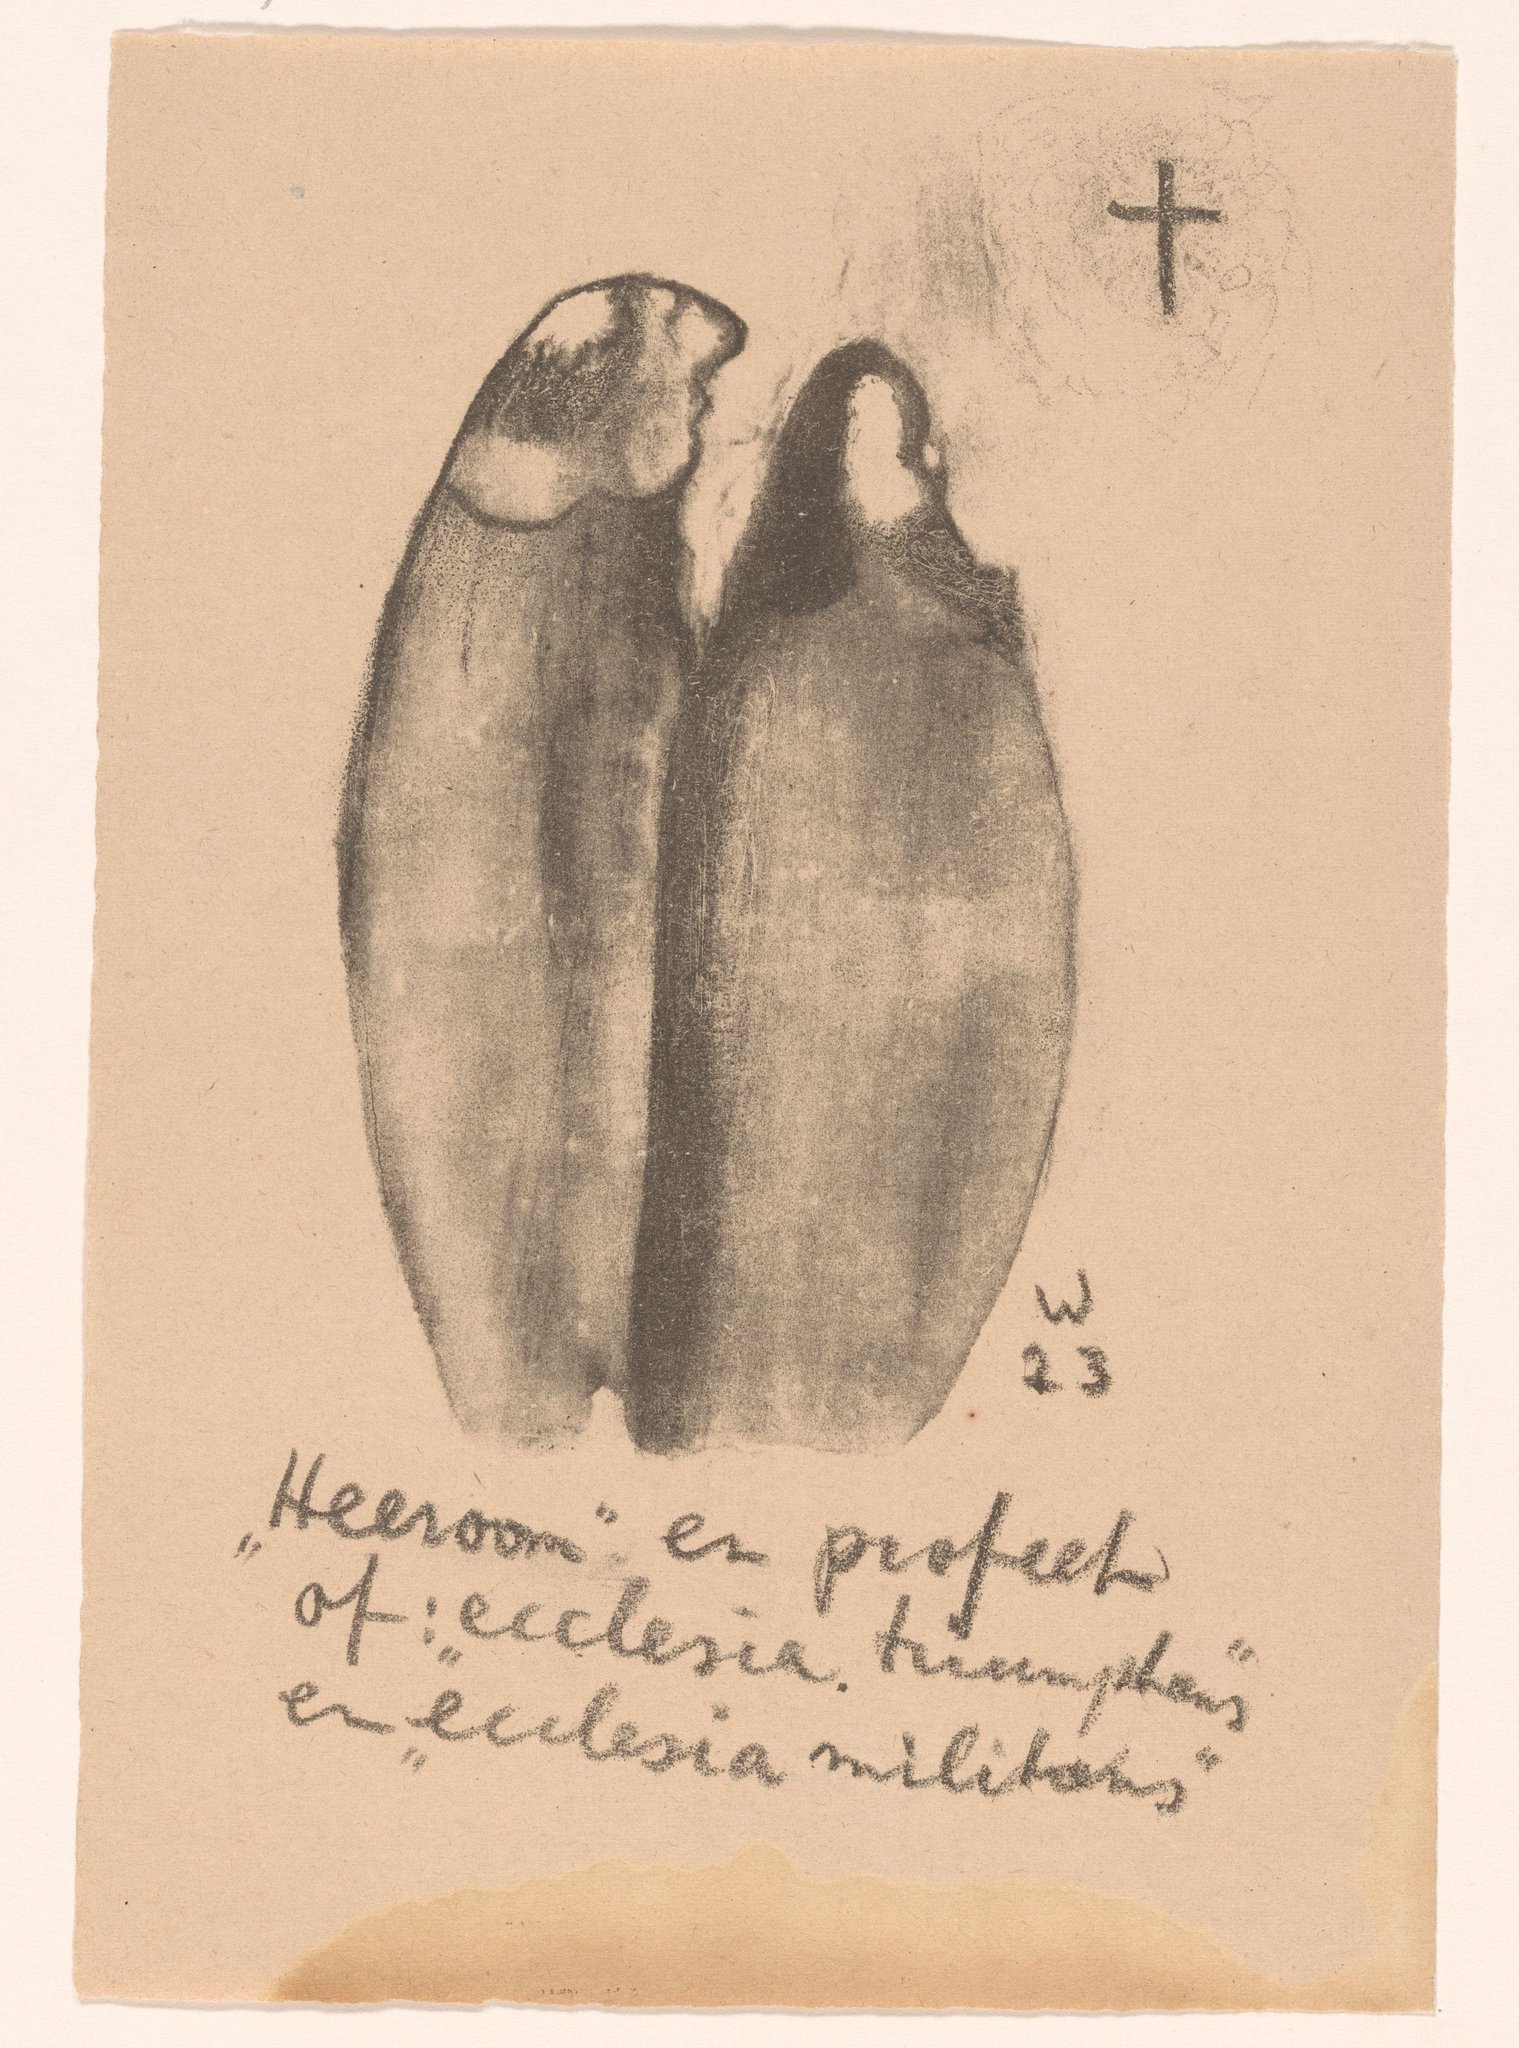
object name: print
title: Idealisten II en verdere Kanttekeningen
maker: erich wichmann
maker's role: print maker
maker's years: 1890-1929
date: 1923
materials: paper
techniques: lithograph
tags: caricatures (human types), organization, functionaries and dignitaries in roman catholic church; clergy in general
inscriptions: collector's mark: Lugt 2228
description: Onderaan de tekst: '"Heeroom" en profeet of: "ecclesia triumphans" en "ecclesia militans"'.